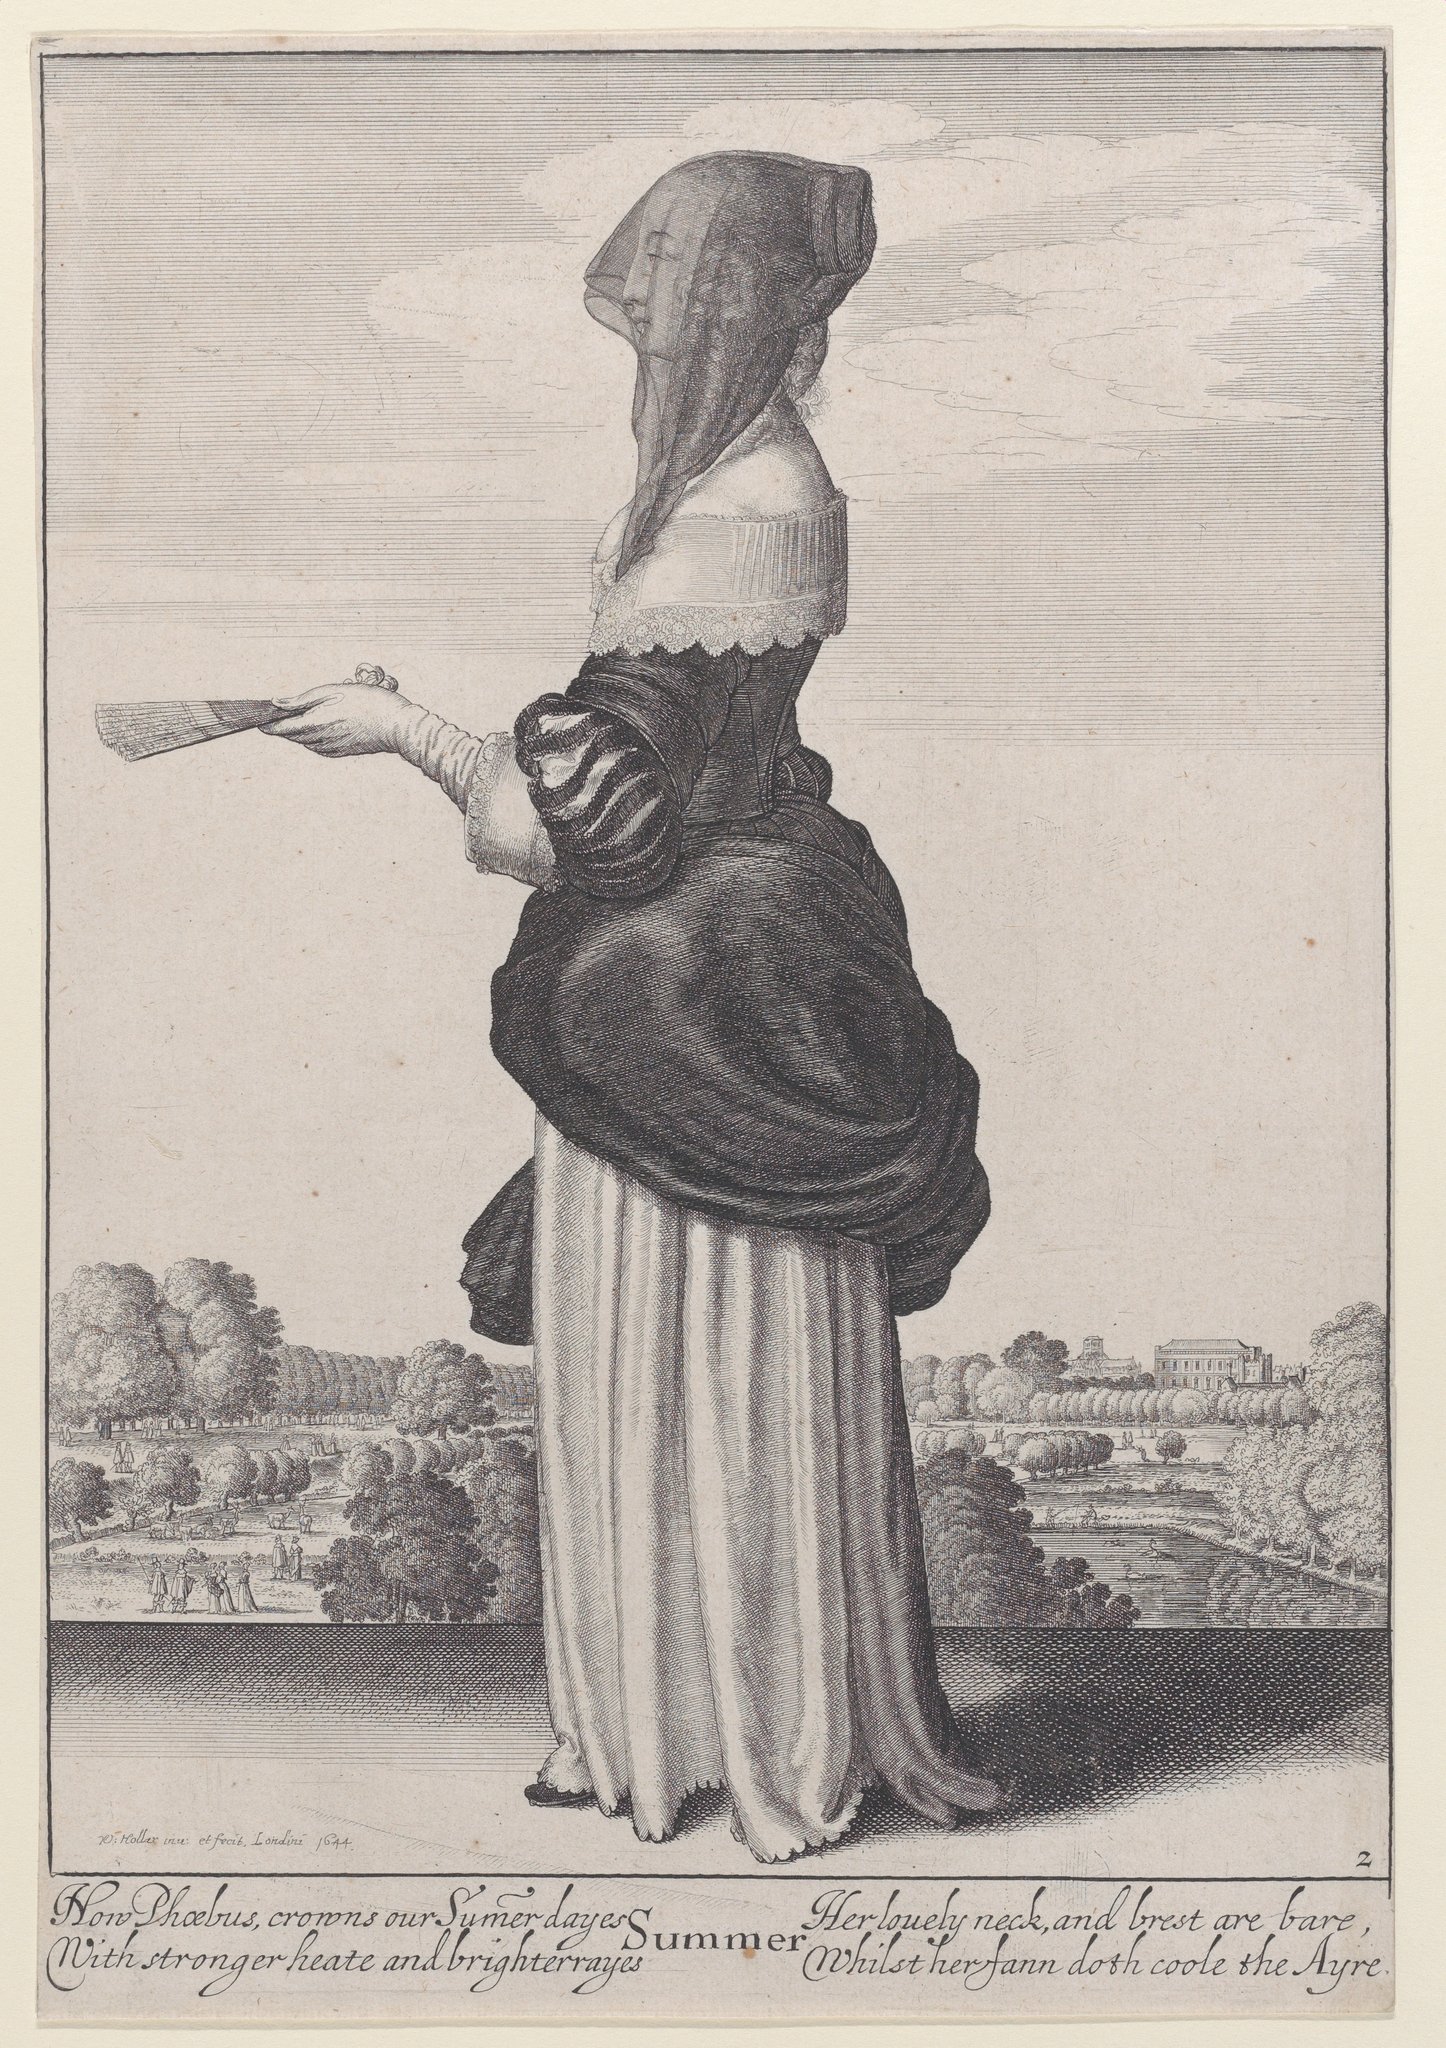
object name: print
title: Summer, from "Full-Length Seasons"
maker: wenceslaus hollar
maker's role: artist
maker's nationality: bohemian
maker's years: 1607-1677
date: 1643-1644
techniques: etching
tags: women